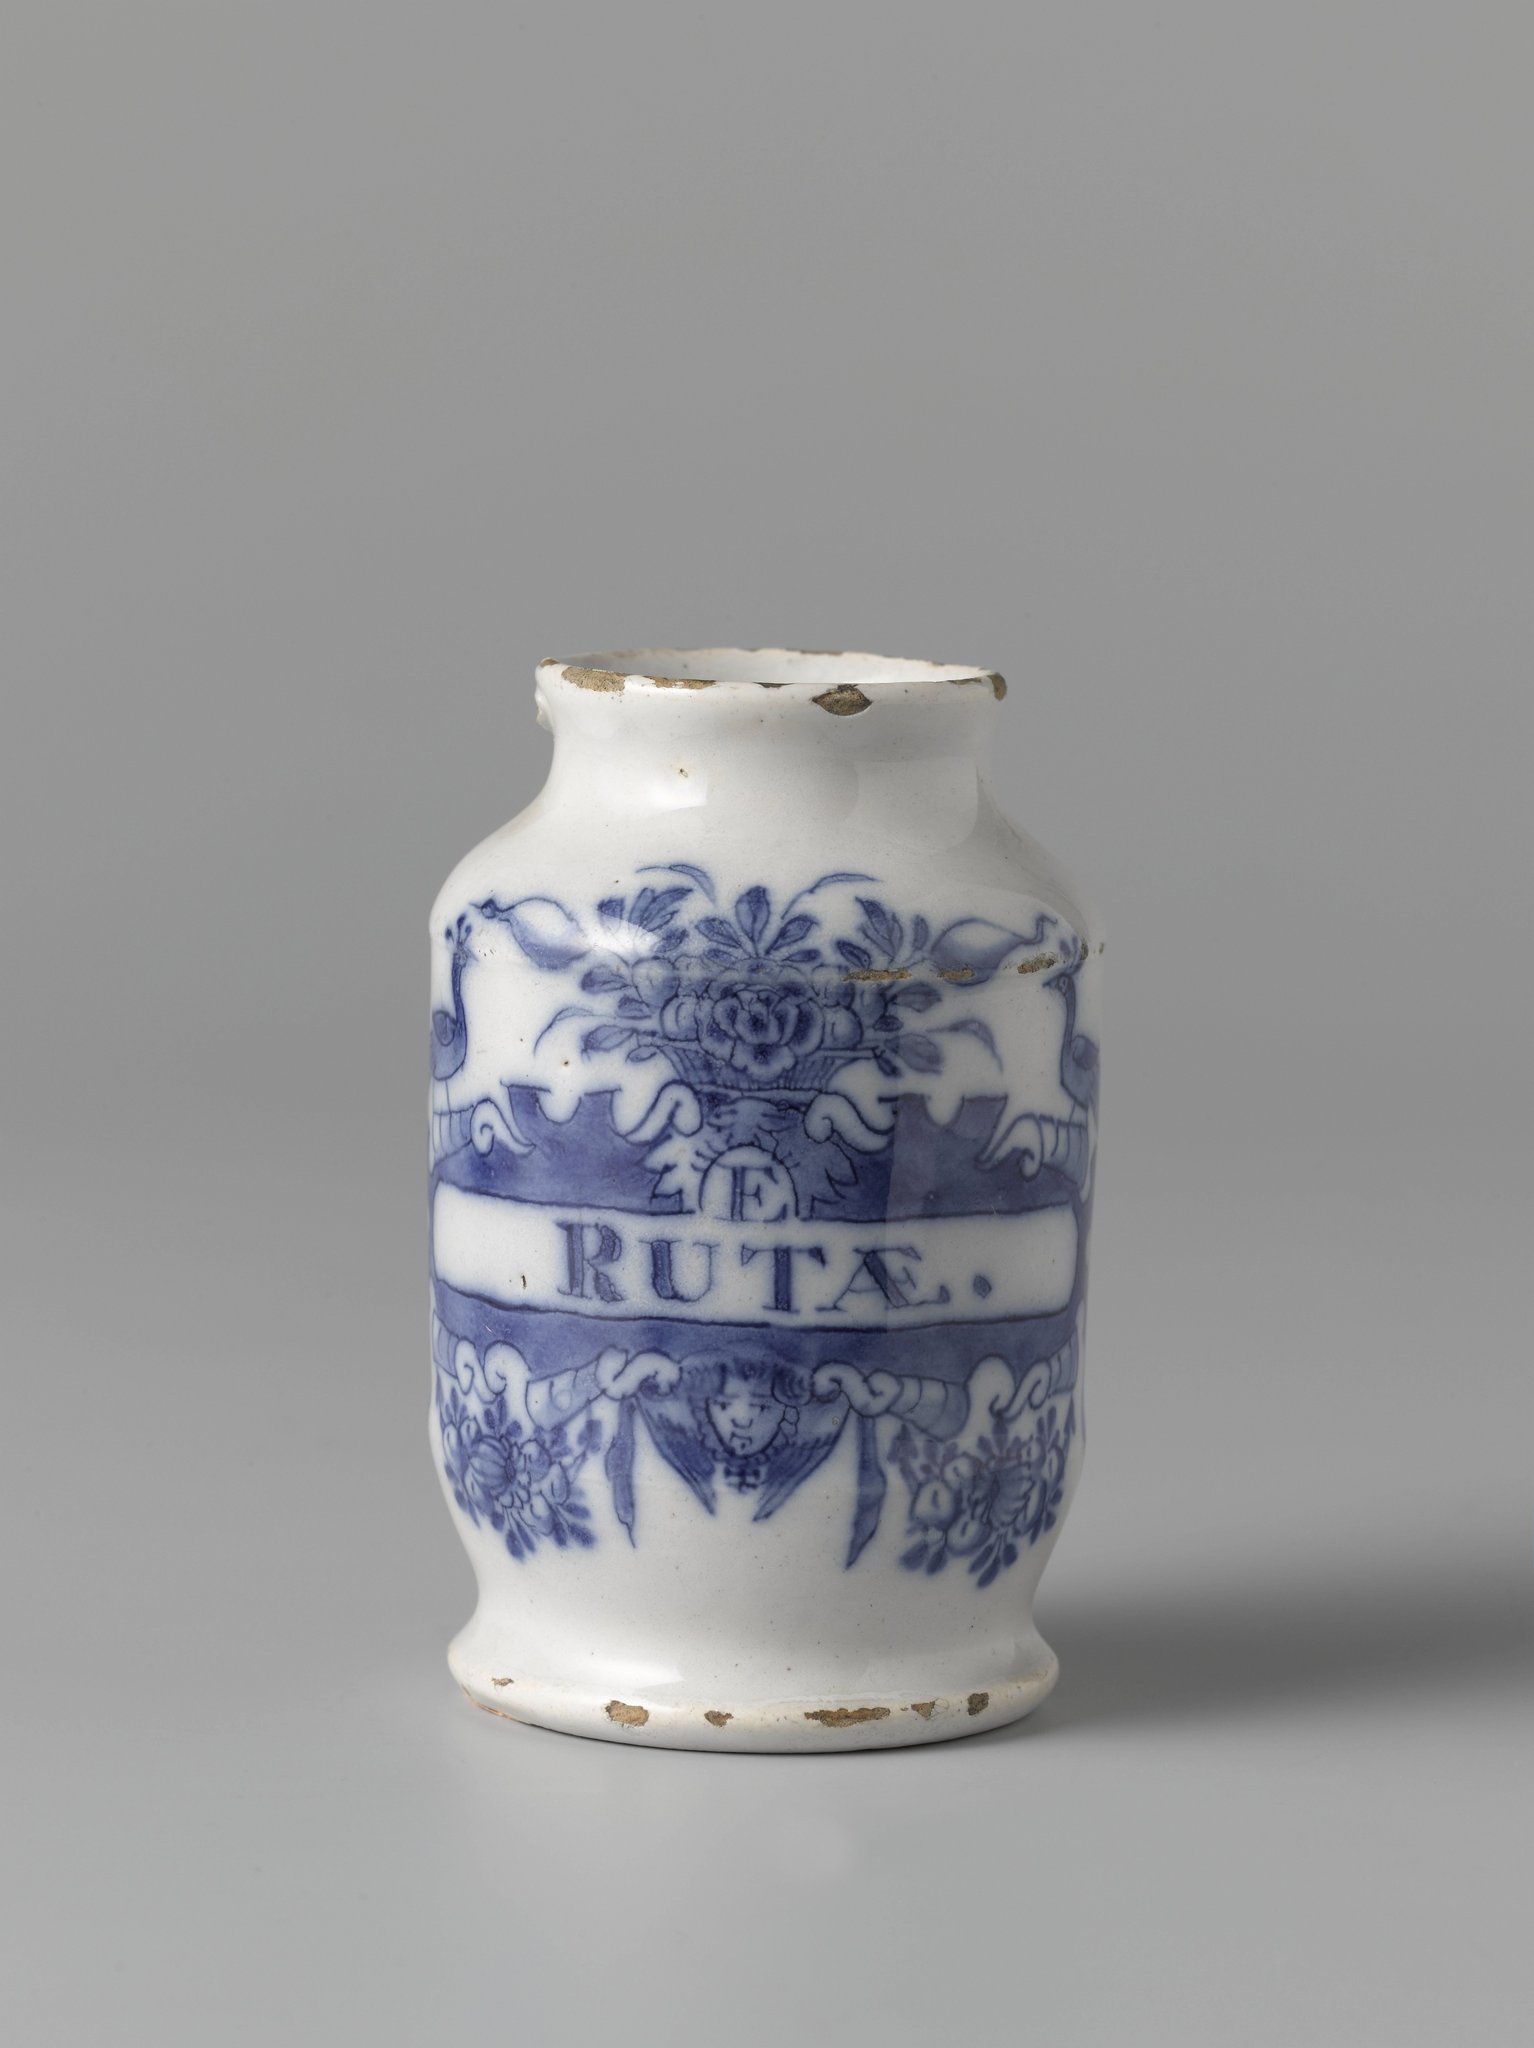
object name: apothecary jar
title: Apothekerspot van faience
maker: Anonymous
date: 1700-1775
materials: earthenware, glaze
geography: delft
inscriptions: mark: ‘TDP’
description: Apothekerspot van faience. Blauw beschilderd met opschrift: E/RUTAE.